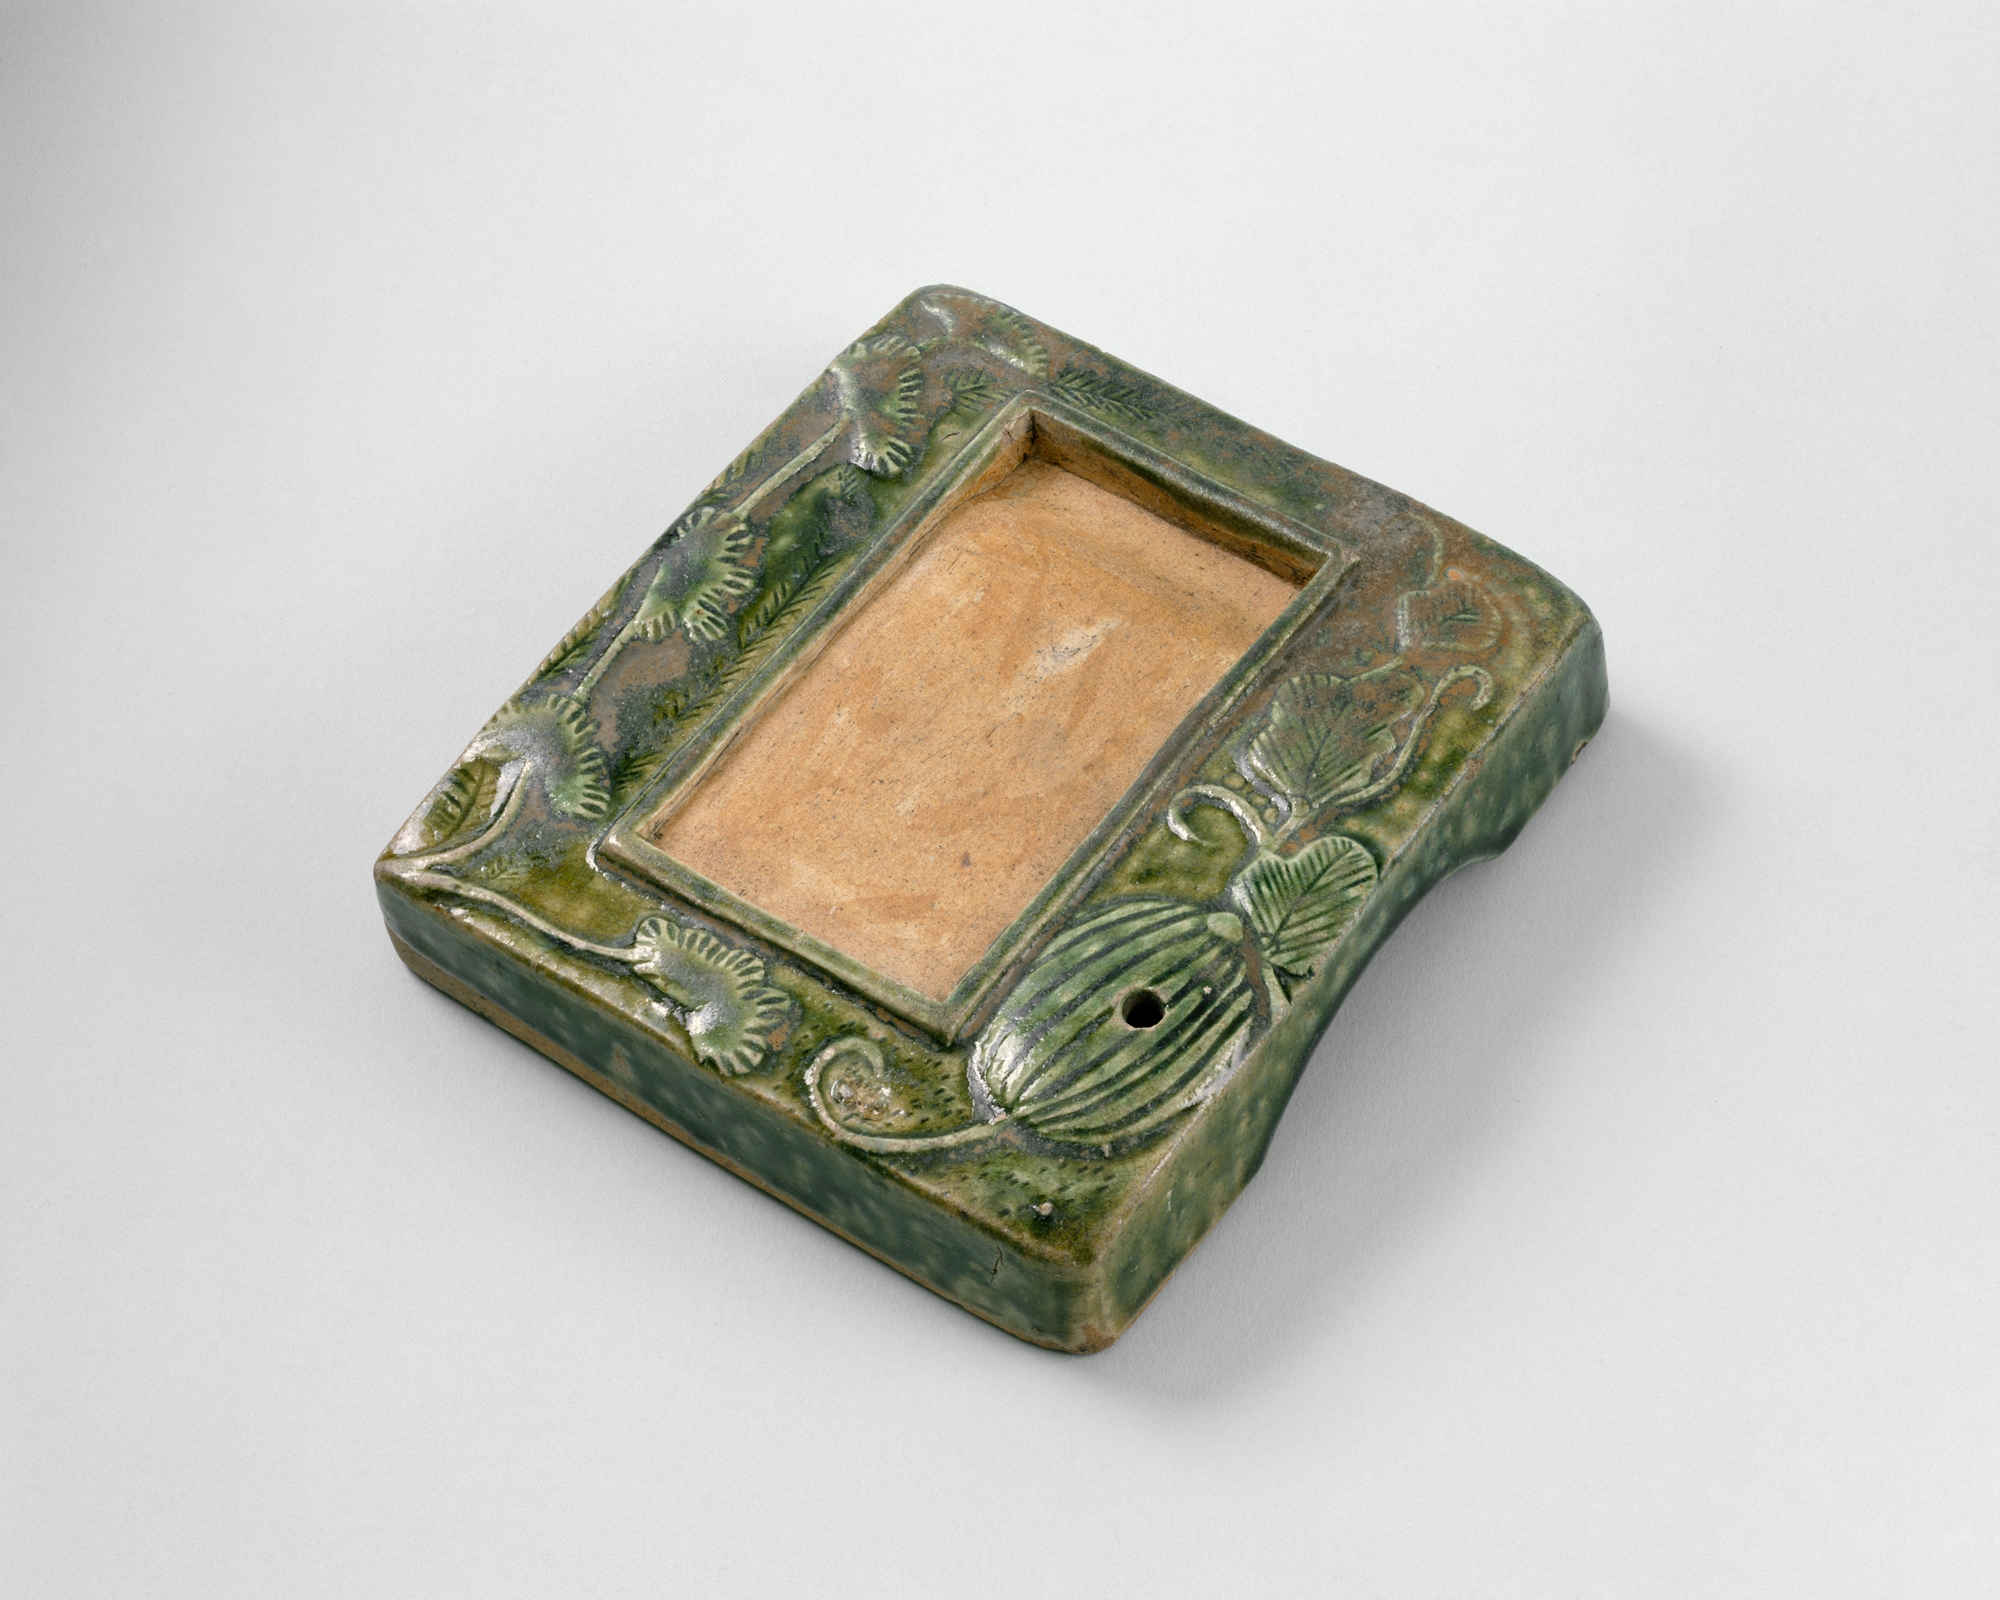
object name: inkstone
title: Inkstone (Suzuri) with Gourd Vine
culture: japanese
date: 1567-1633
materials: copper, glaze, stoneware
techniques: molding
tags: vines